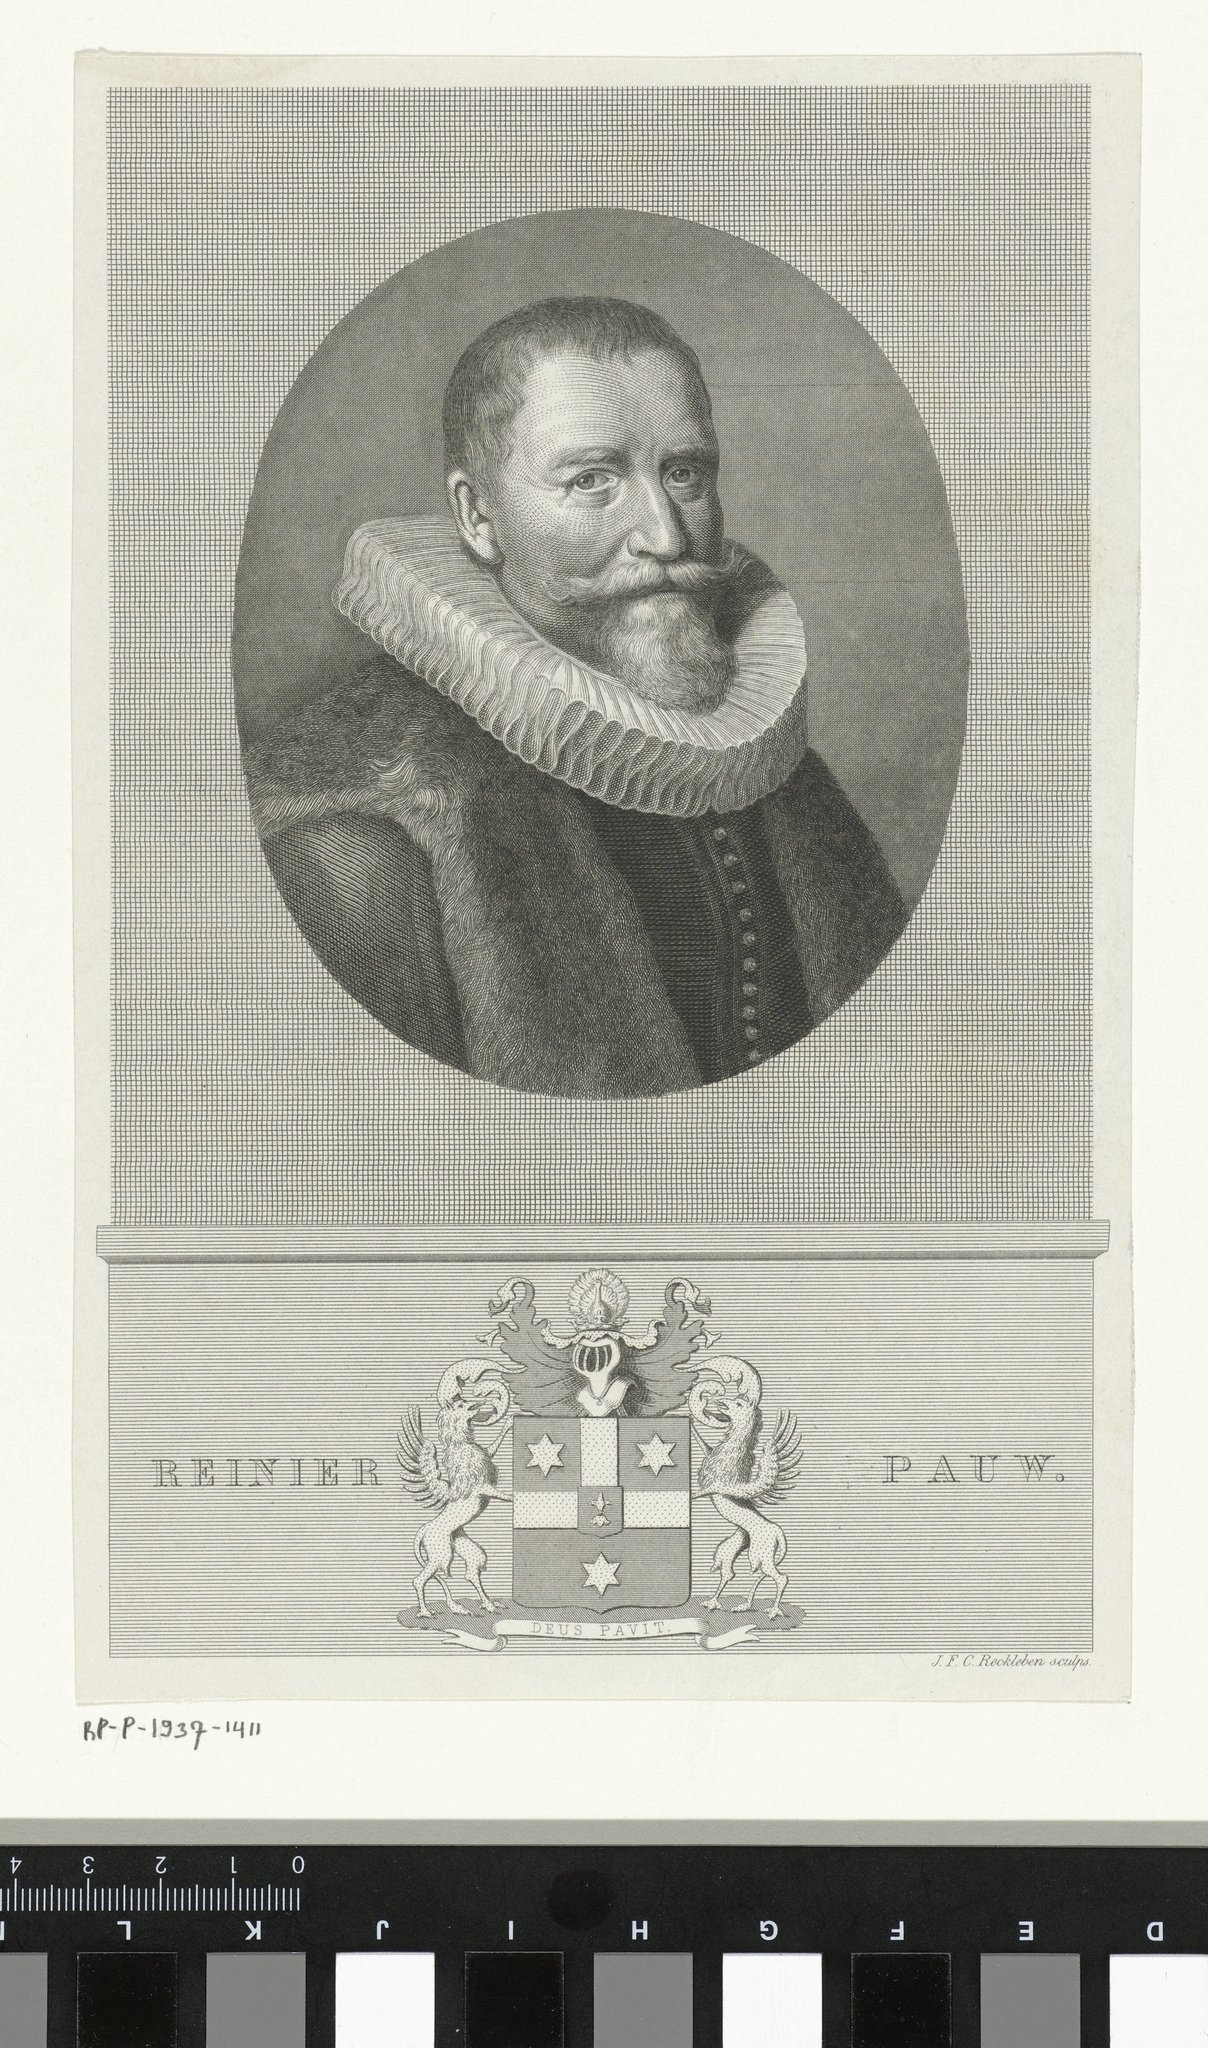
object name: print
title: Portret van Reinier Adriaensz. Pauw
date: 1858-1860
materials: paper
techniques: engraving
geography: amsterdam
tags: amsterdam, mayor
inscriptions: collector's mark: Lugt 2228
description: Illustratie in: Arend, Johannes Pieter. Algemeene geschiedenis des vaderlands van de vroegste tijden tot op heden. 5 delen, Amsterdam: Schleijer, J.F. 1840-1884, dl. 3.3, p. 87.